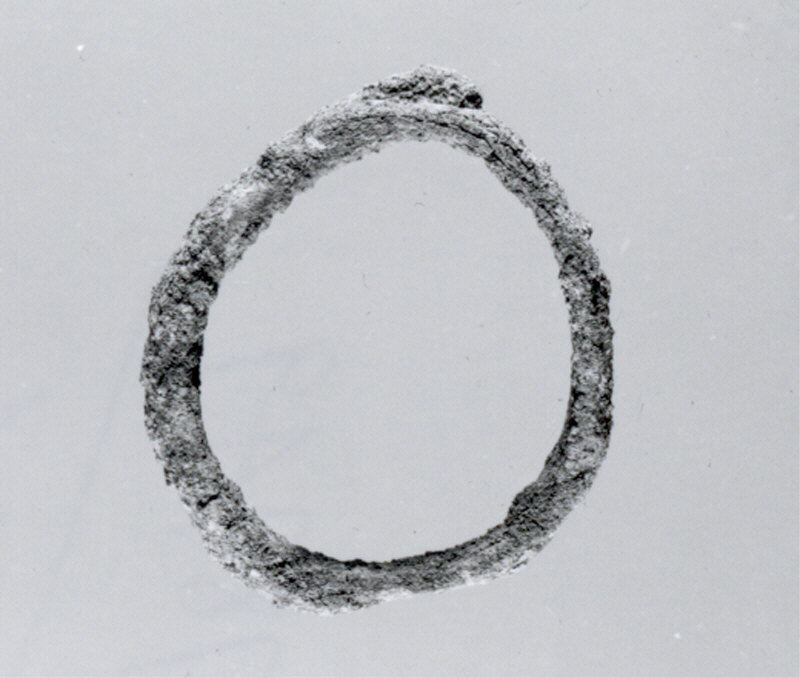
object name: bracelet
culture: iranian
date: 2800 BCE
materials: copper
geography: iran